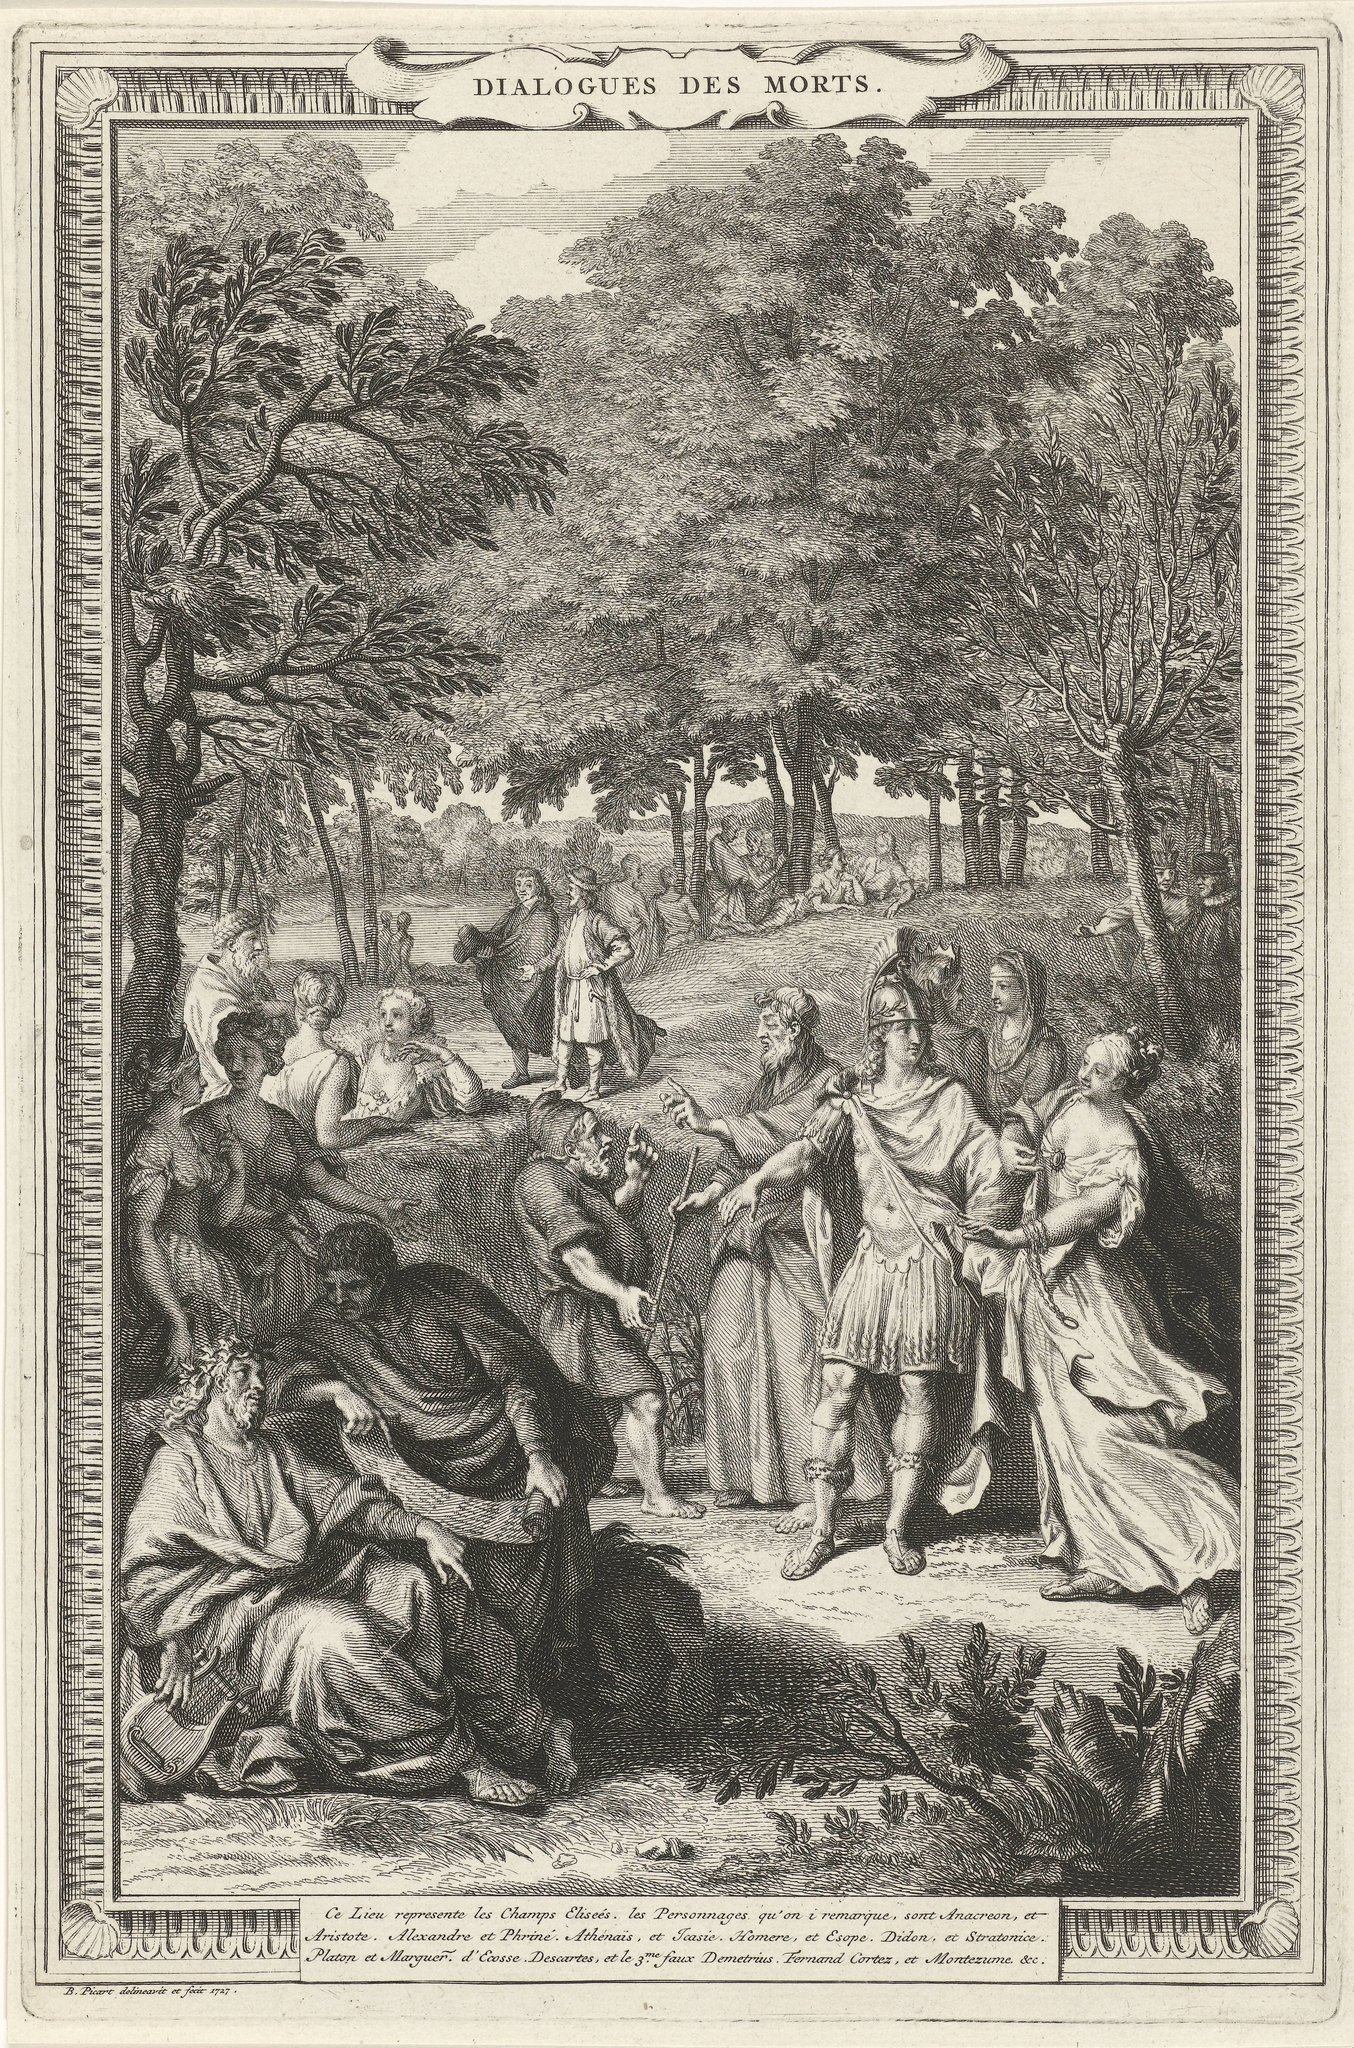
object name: book illustration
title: Dialogues des morts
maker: bernard picart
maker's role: draughtsman, print maker, publisher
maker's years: 1673-1733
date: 1727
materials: paper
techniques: engraving, etching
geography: amsterdam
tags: homerus, aesopus, elysium, elysian fields; islands of the blessed, debate, discussion (~ meeting)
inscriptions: collector's mark: Lugt 2233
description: Allegorische voorstelling met overleden filosofen en schrijvers die discussiëren met elkaar in het Elysium. Links op de voorgrond de Griekse lierdichter Anakreon in gesprek met Aristoteles. In het midden Homerus en Aesop, Alexander de Grote en de courtisane Phryne. Op de achtergrond nog meer historische figuren. In de marge een drieregelig onderschrift in het Frans.